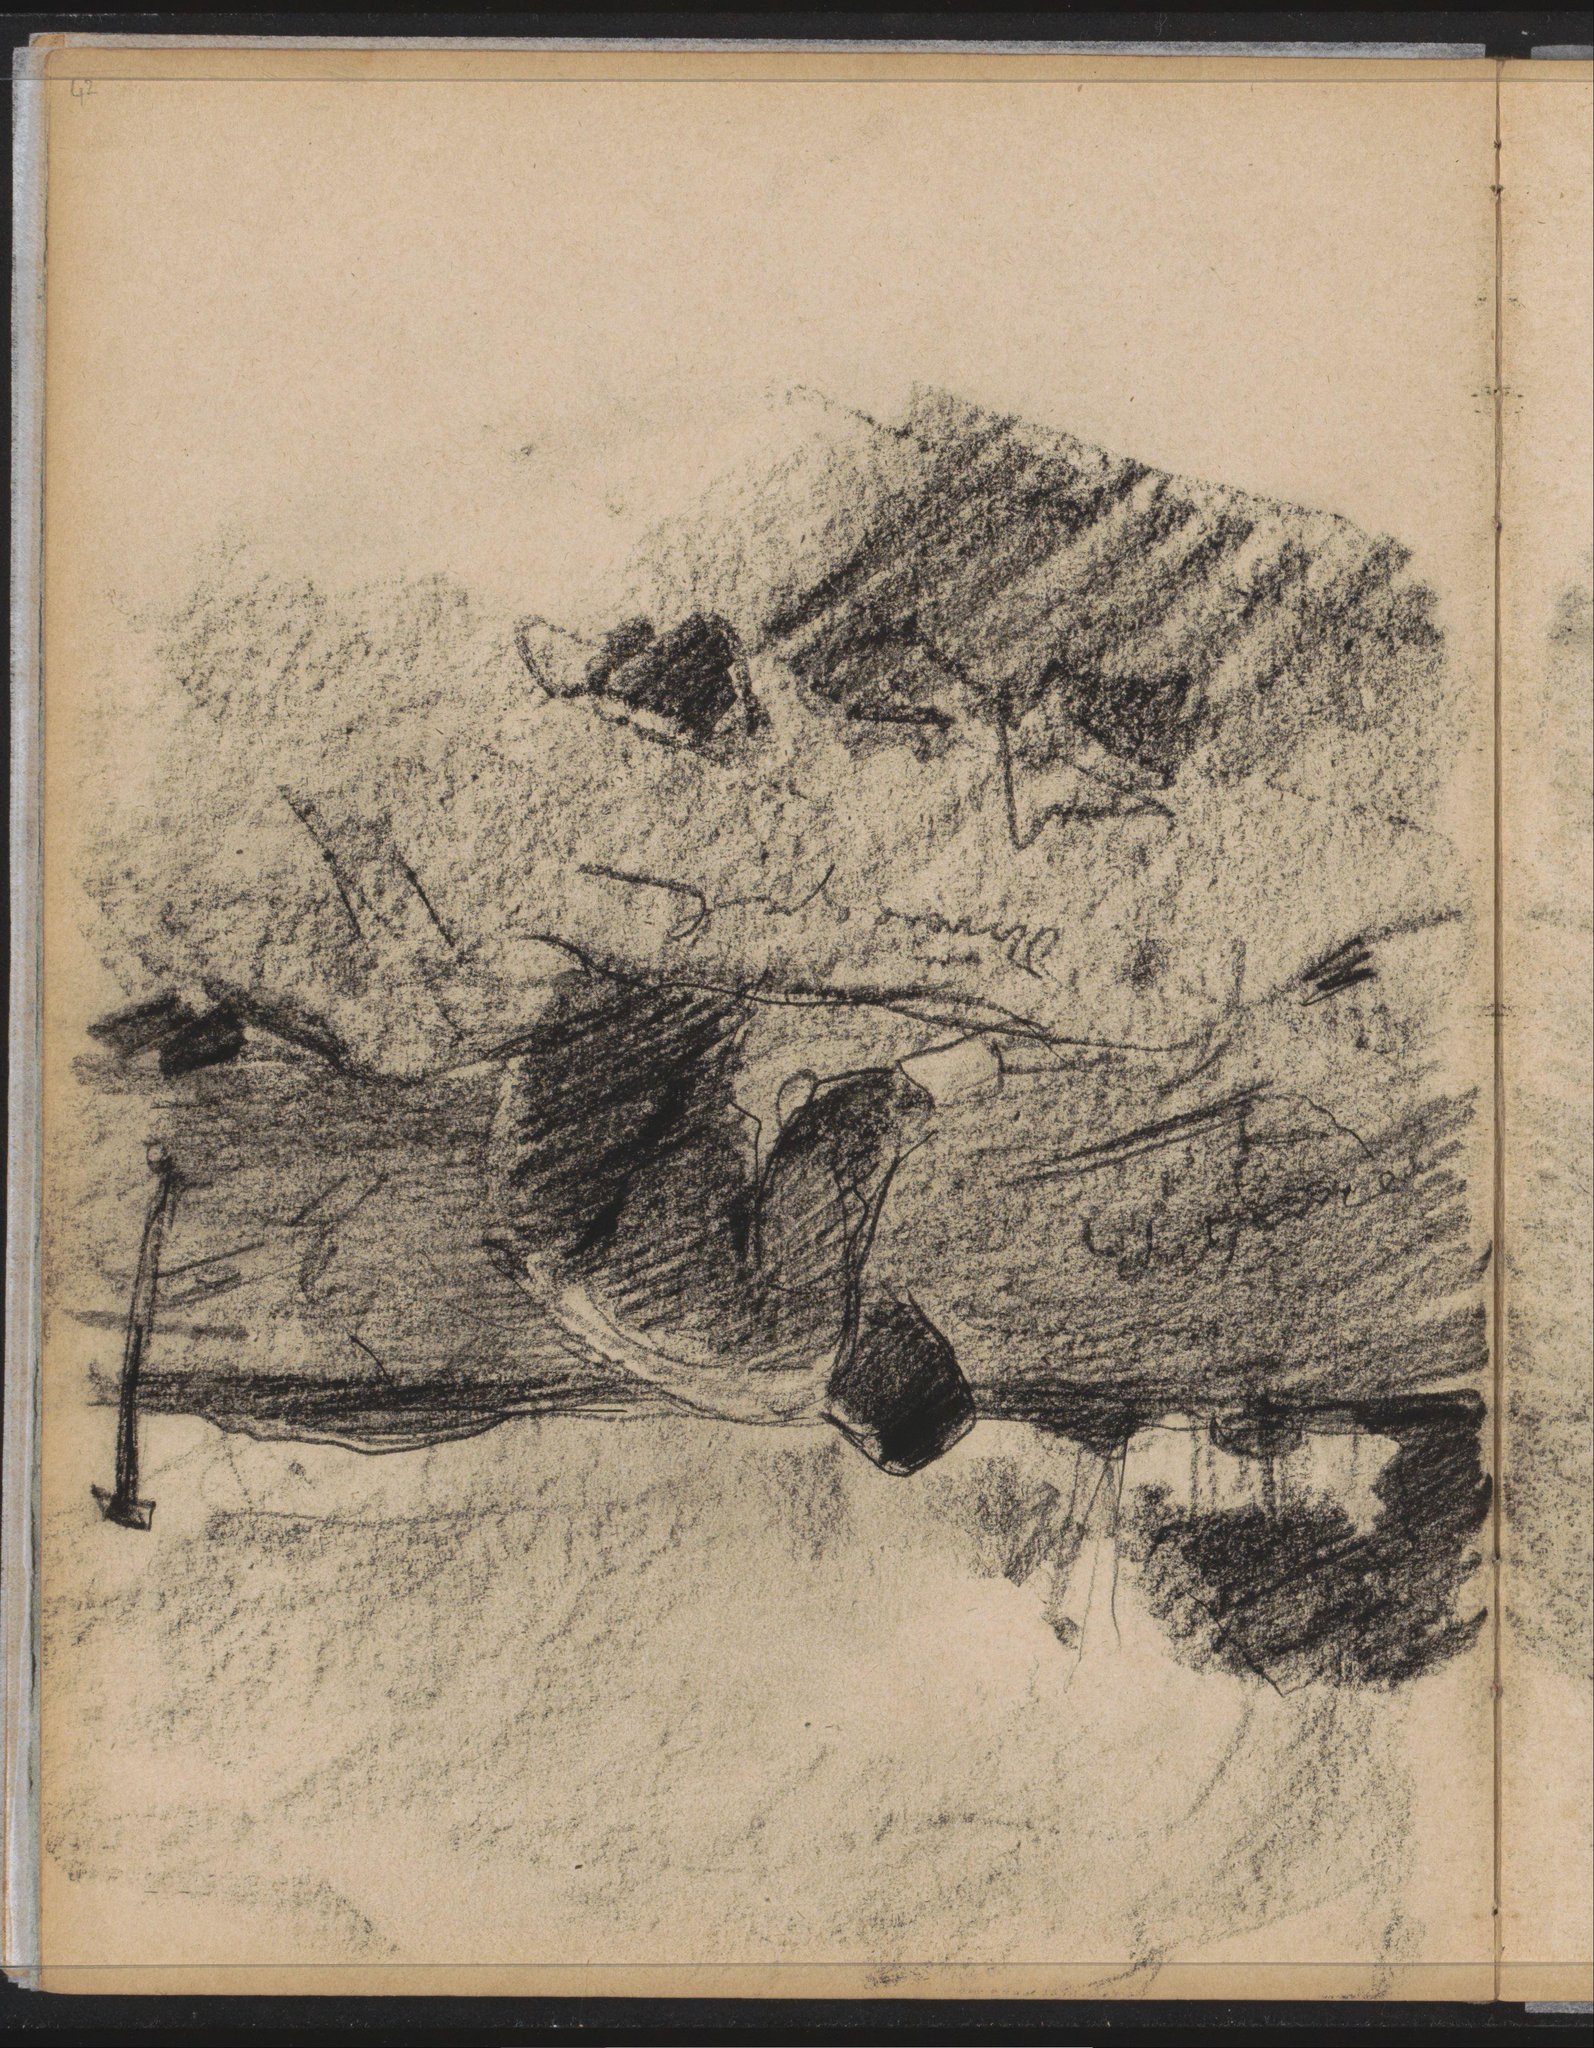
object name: sketchbook leaf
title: Heiwerker op het land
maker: willem witsen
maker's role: draughtsman, painter, print maker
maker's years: 1860-1923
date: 1884-1887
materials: chalk, paper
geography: ewijkshoeve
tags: building-site (+ men (labourers))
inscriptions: kleurnotitie, handgeschreven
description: Pagina 42 uit een schetsboek met 49 bladen.